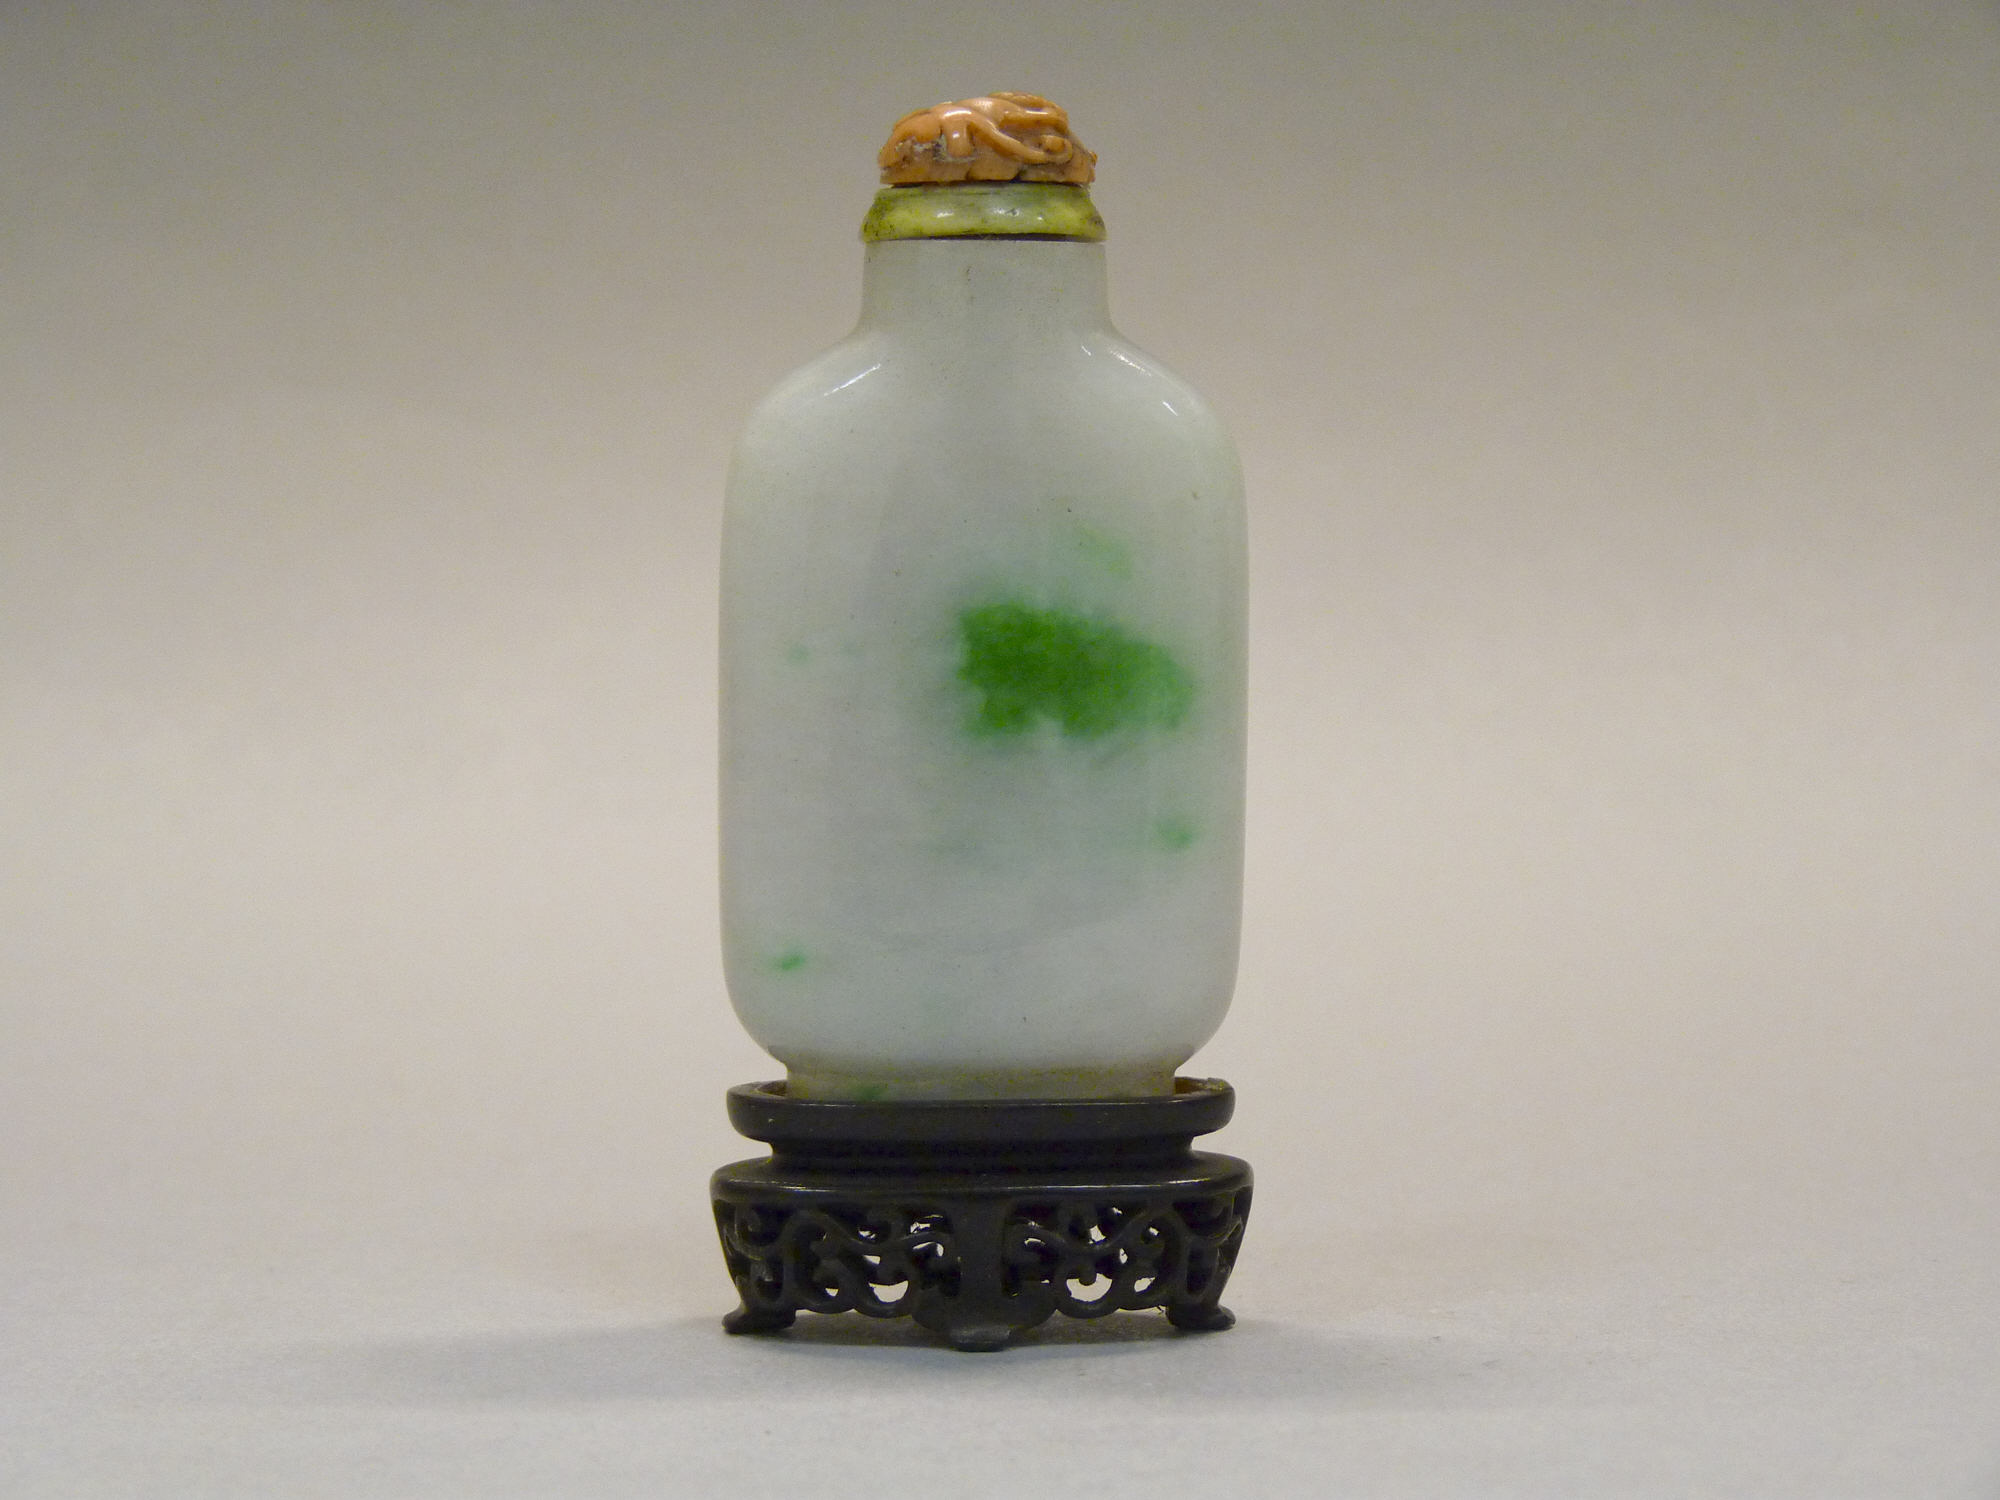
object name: snuff bottle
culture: chinese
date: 1736-1795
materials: coral, jade